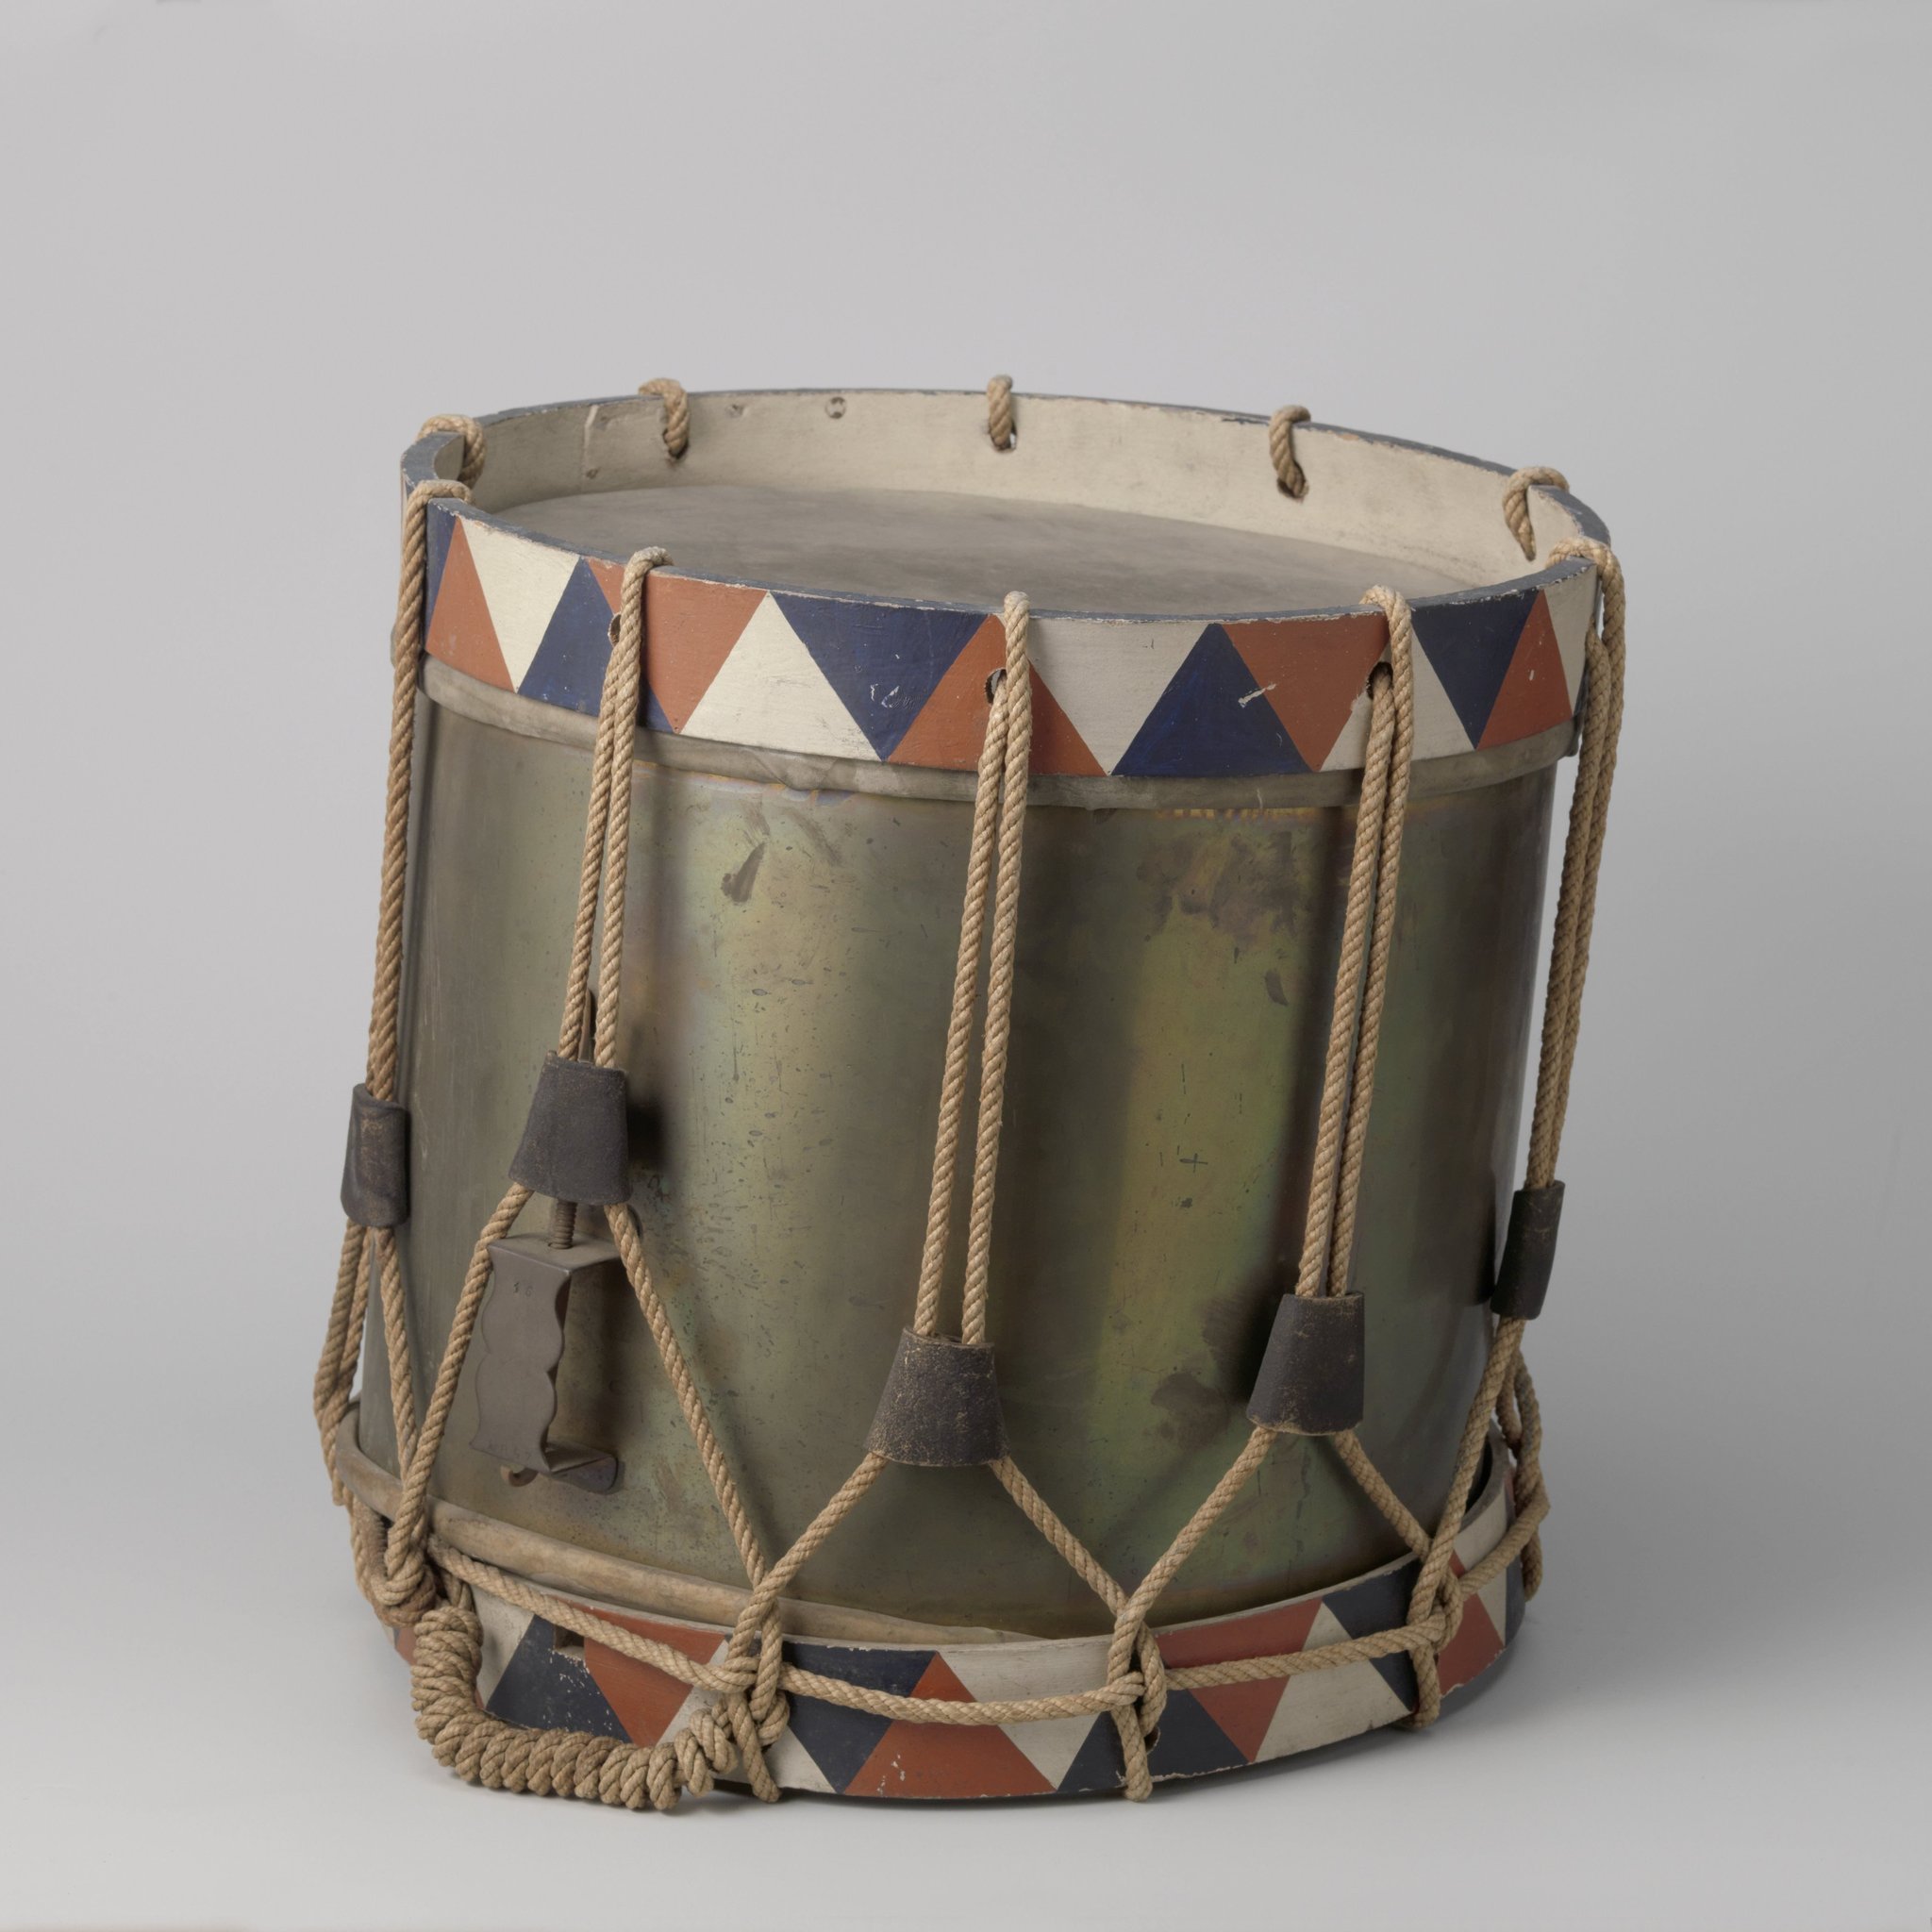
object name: percussion instrument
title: Side Drums (39 x)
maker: Anonymous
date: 1847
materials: brass, fiber, skin, wood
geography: netherlands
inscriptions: inscription: ‘1847-16’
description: Music has always been a crucial element of public celebrations, such as military parades, coronations, royal weddings, and funerals, adding grandeur to the solemnity of the occasion. Musical ensembles entrusted with performing music at these events have existed in Europe since the Middle Ages. This display highlights various marching bands and their musical instruments dating from the 16th to the 19th century.